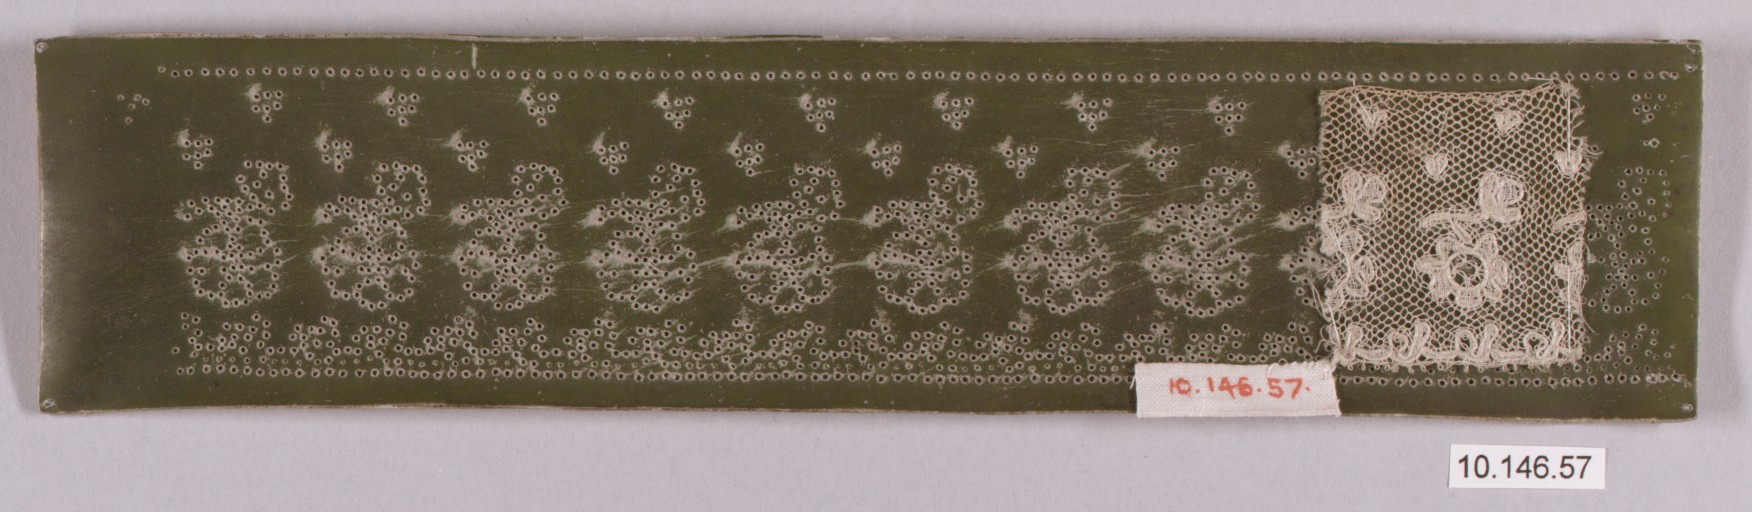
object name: bobbin lace and pattern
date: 1701-1800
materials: lace